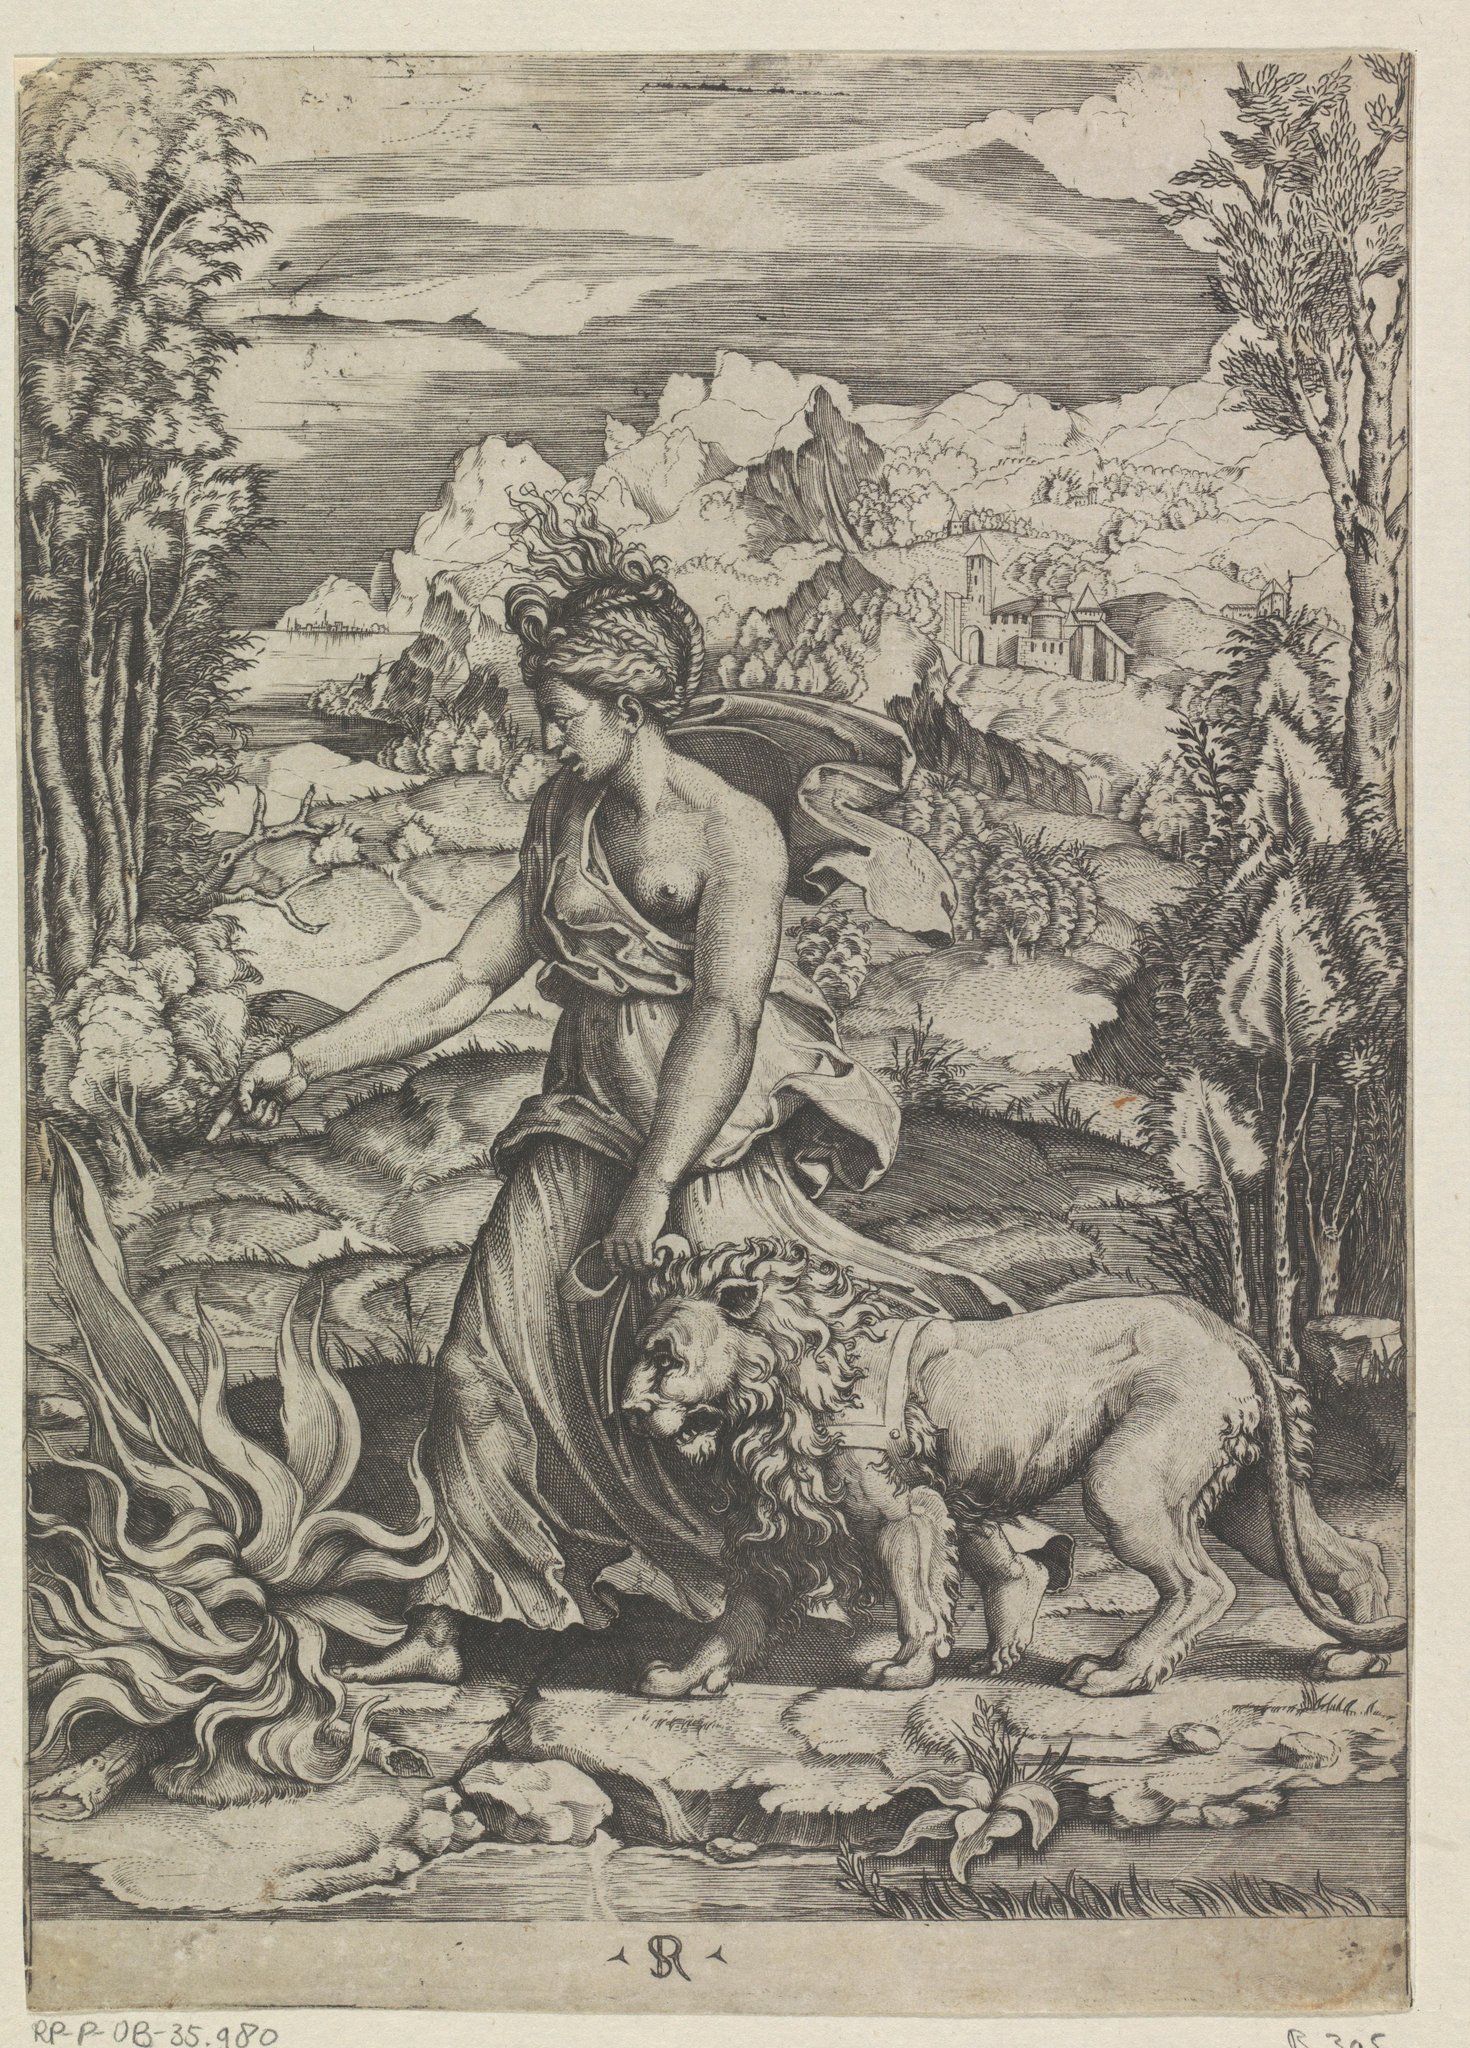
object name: print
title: Sterkte (fortitudo)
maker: marco dente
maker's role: print maker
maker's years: 1486-1527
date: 1498-1532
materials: paper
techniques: engraving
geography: italy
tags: fortitude, 'fortitudo' ~ one of the four cardinal virtues, beasts of prey, predatory animals: lion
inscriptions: collector's mark: Lugt 240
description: Een vrouw (Fortitudo) leidt een leeuw aan een tuigje door een landschap richting een brandend vuur.